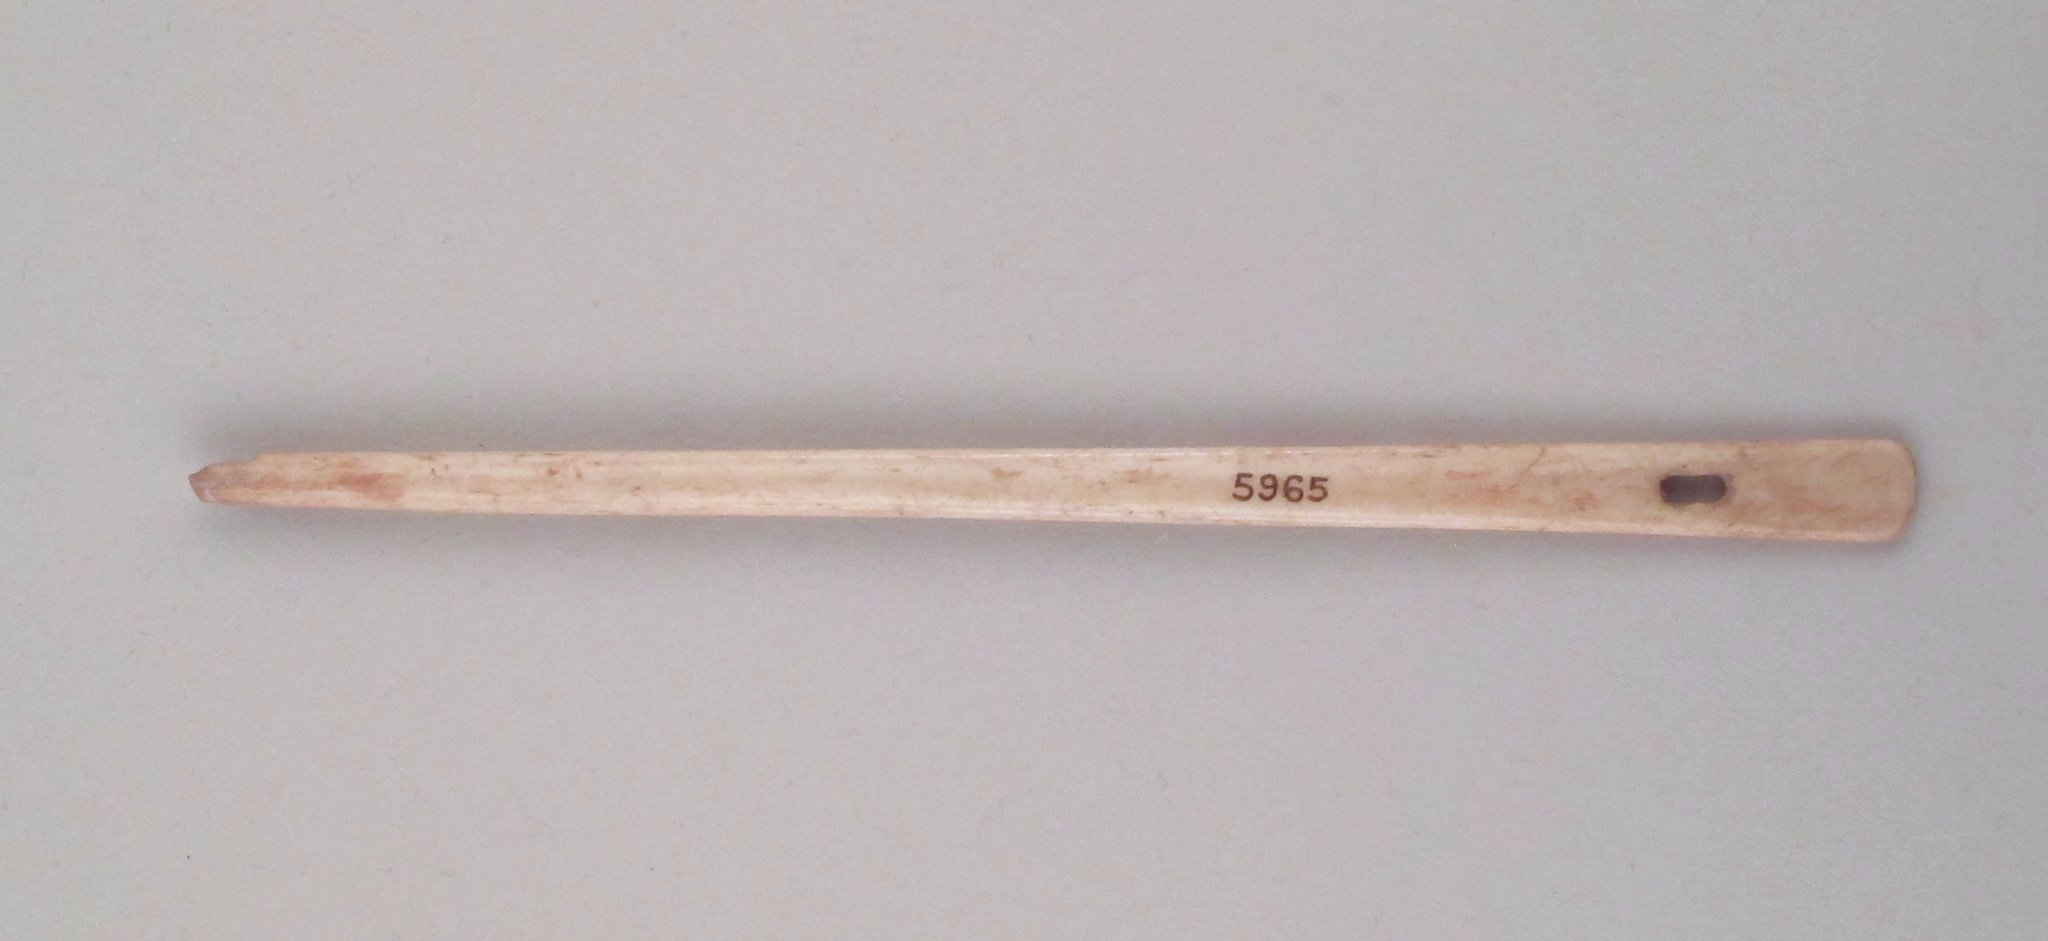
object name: spatula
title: Bone spatulated needle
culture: cypriot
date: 1-200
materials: bone